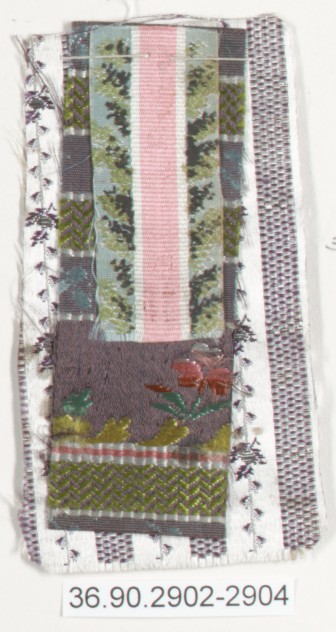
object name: piece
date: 1801-1900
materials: silk